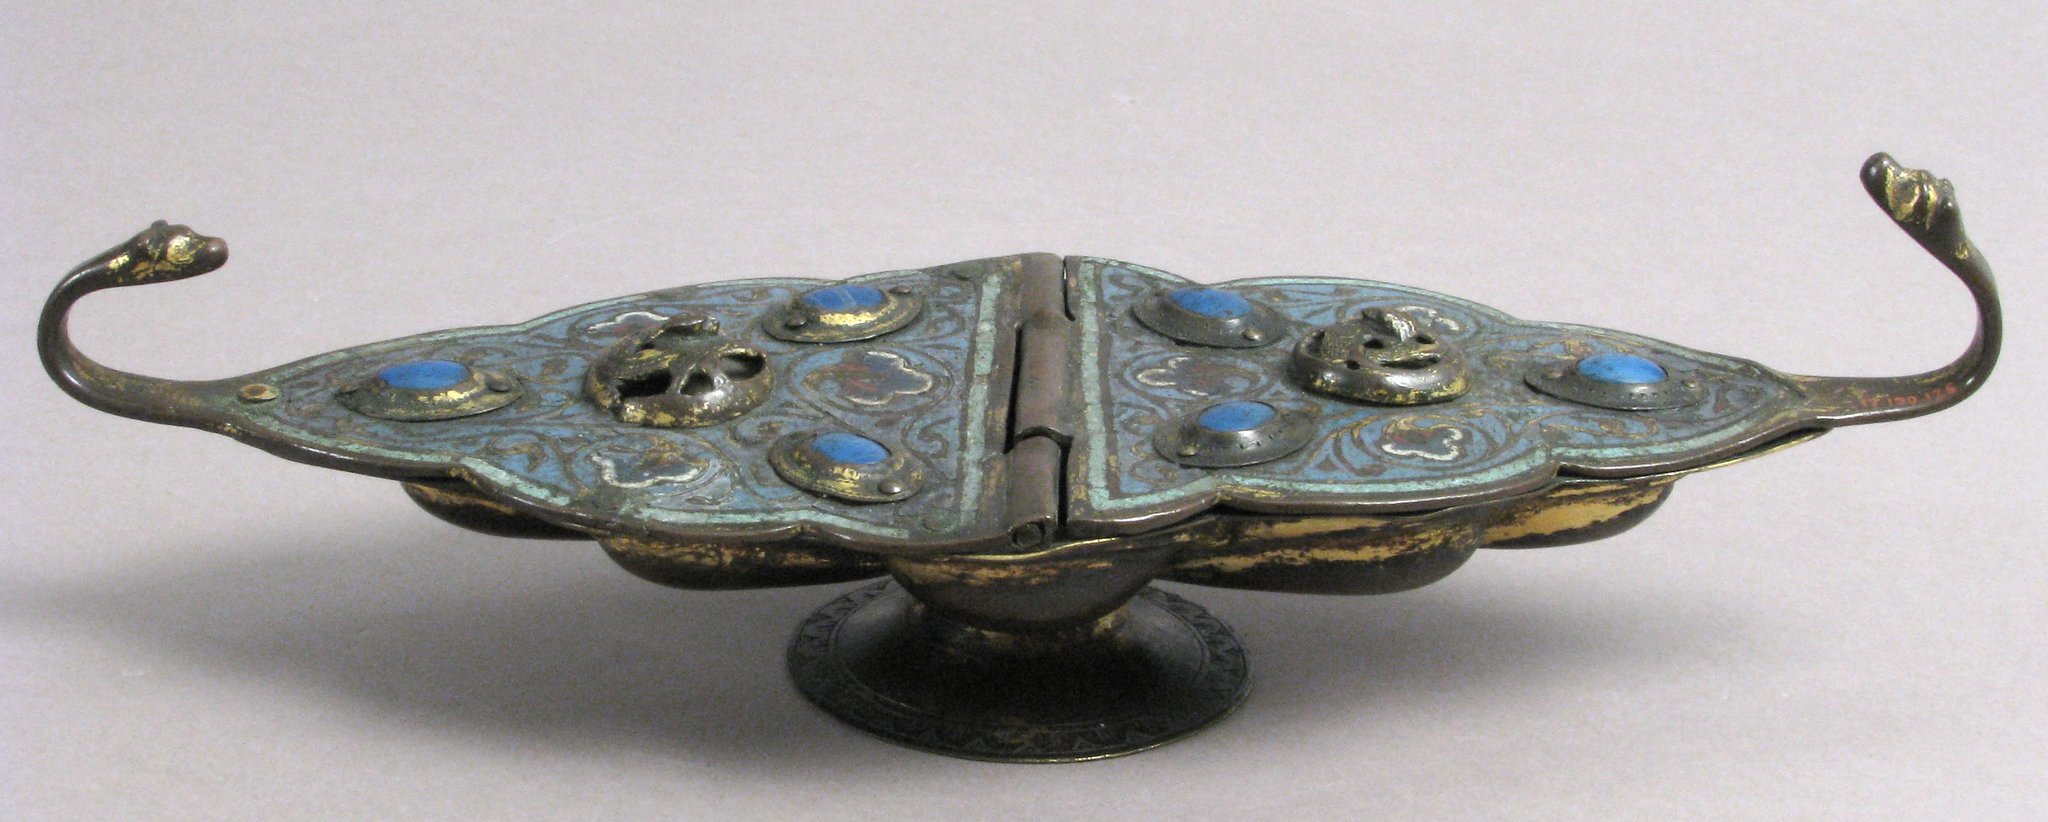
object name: incense boat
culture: french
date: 1250-1270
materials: gilt copper, enamel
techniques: enamel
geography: france